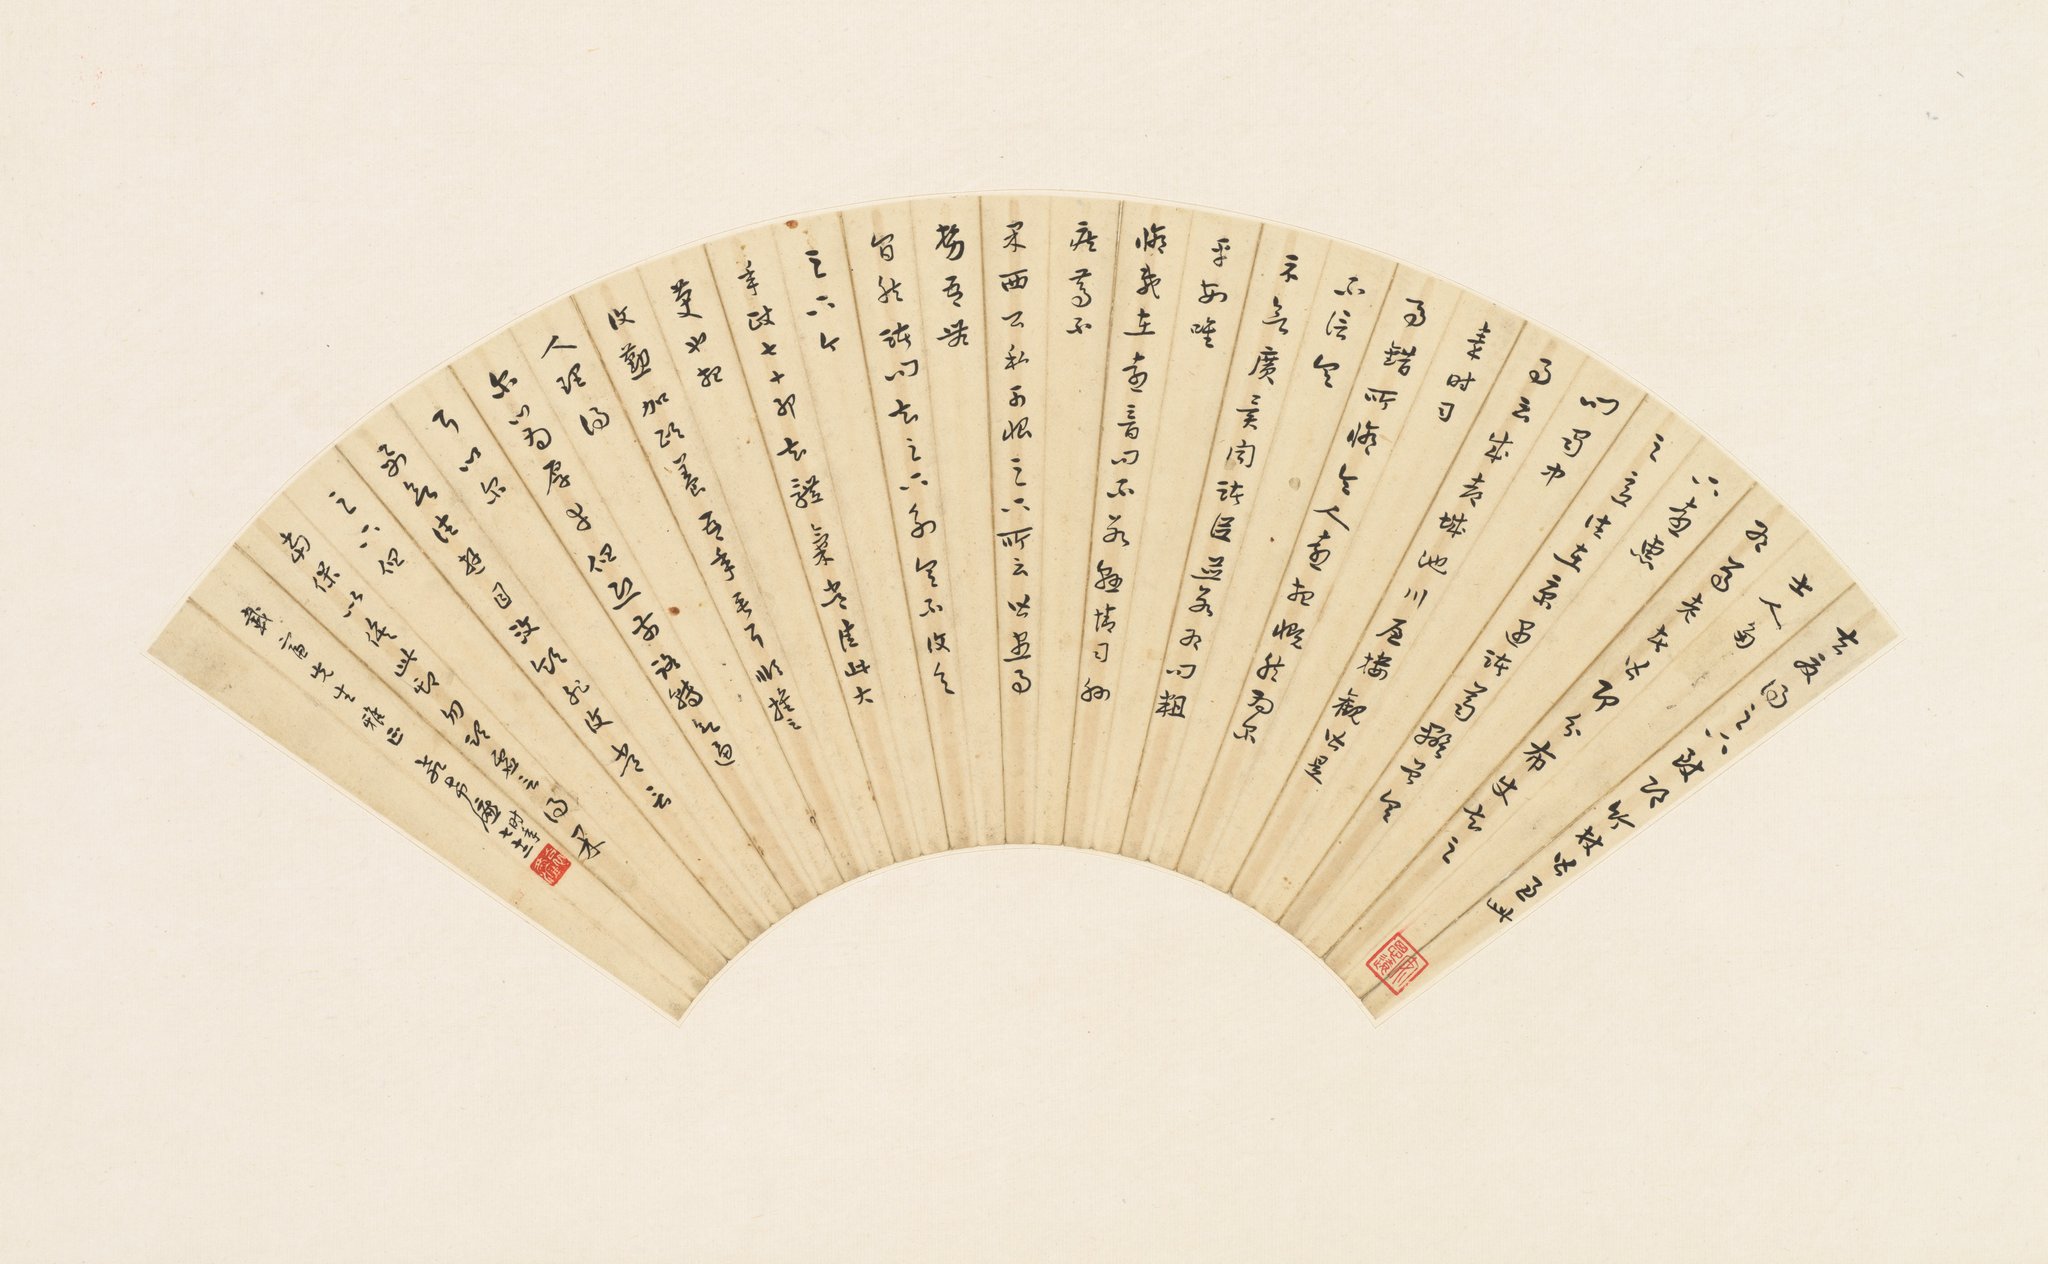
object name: folding fan mounted a an album leaf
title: Calligraphy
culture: chinese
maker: yuan xilian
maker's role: artist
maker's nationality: chinese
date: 1901-2000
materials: ink, paper